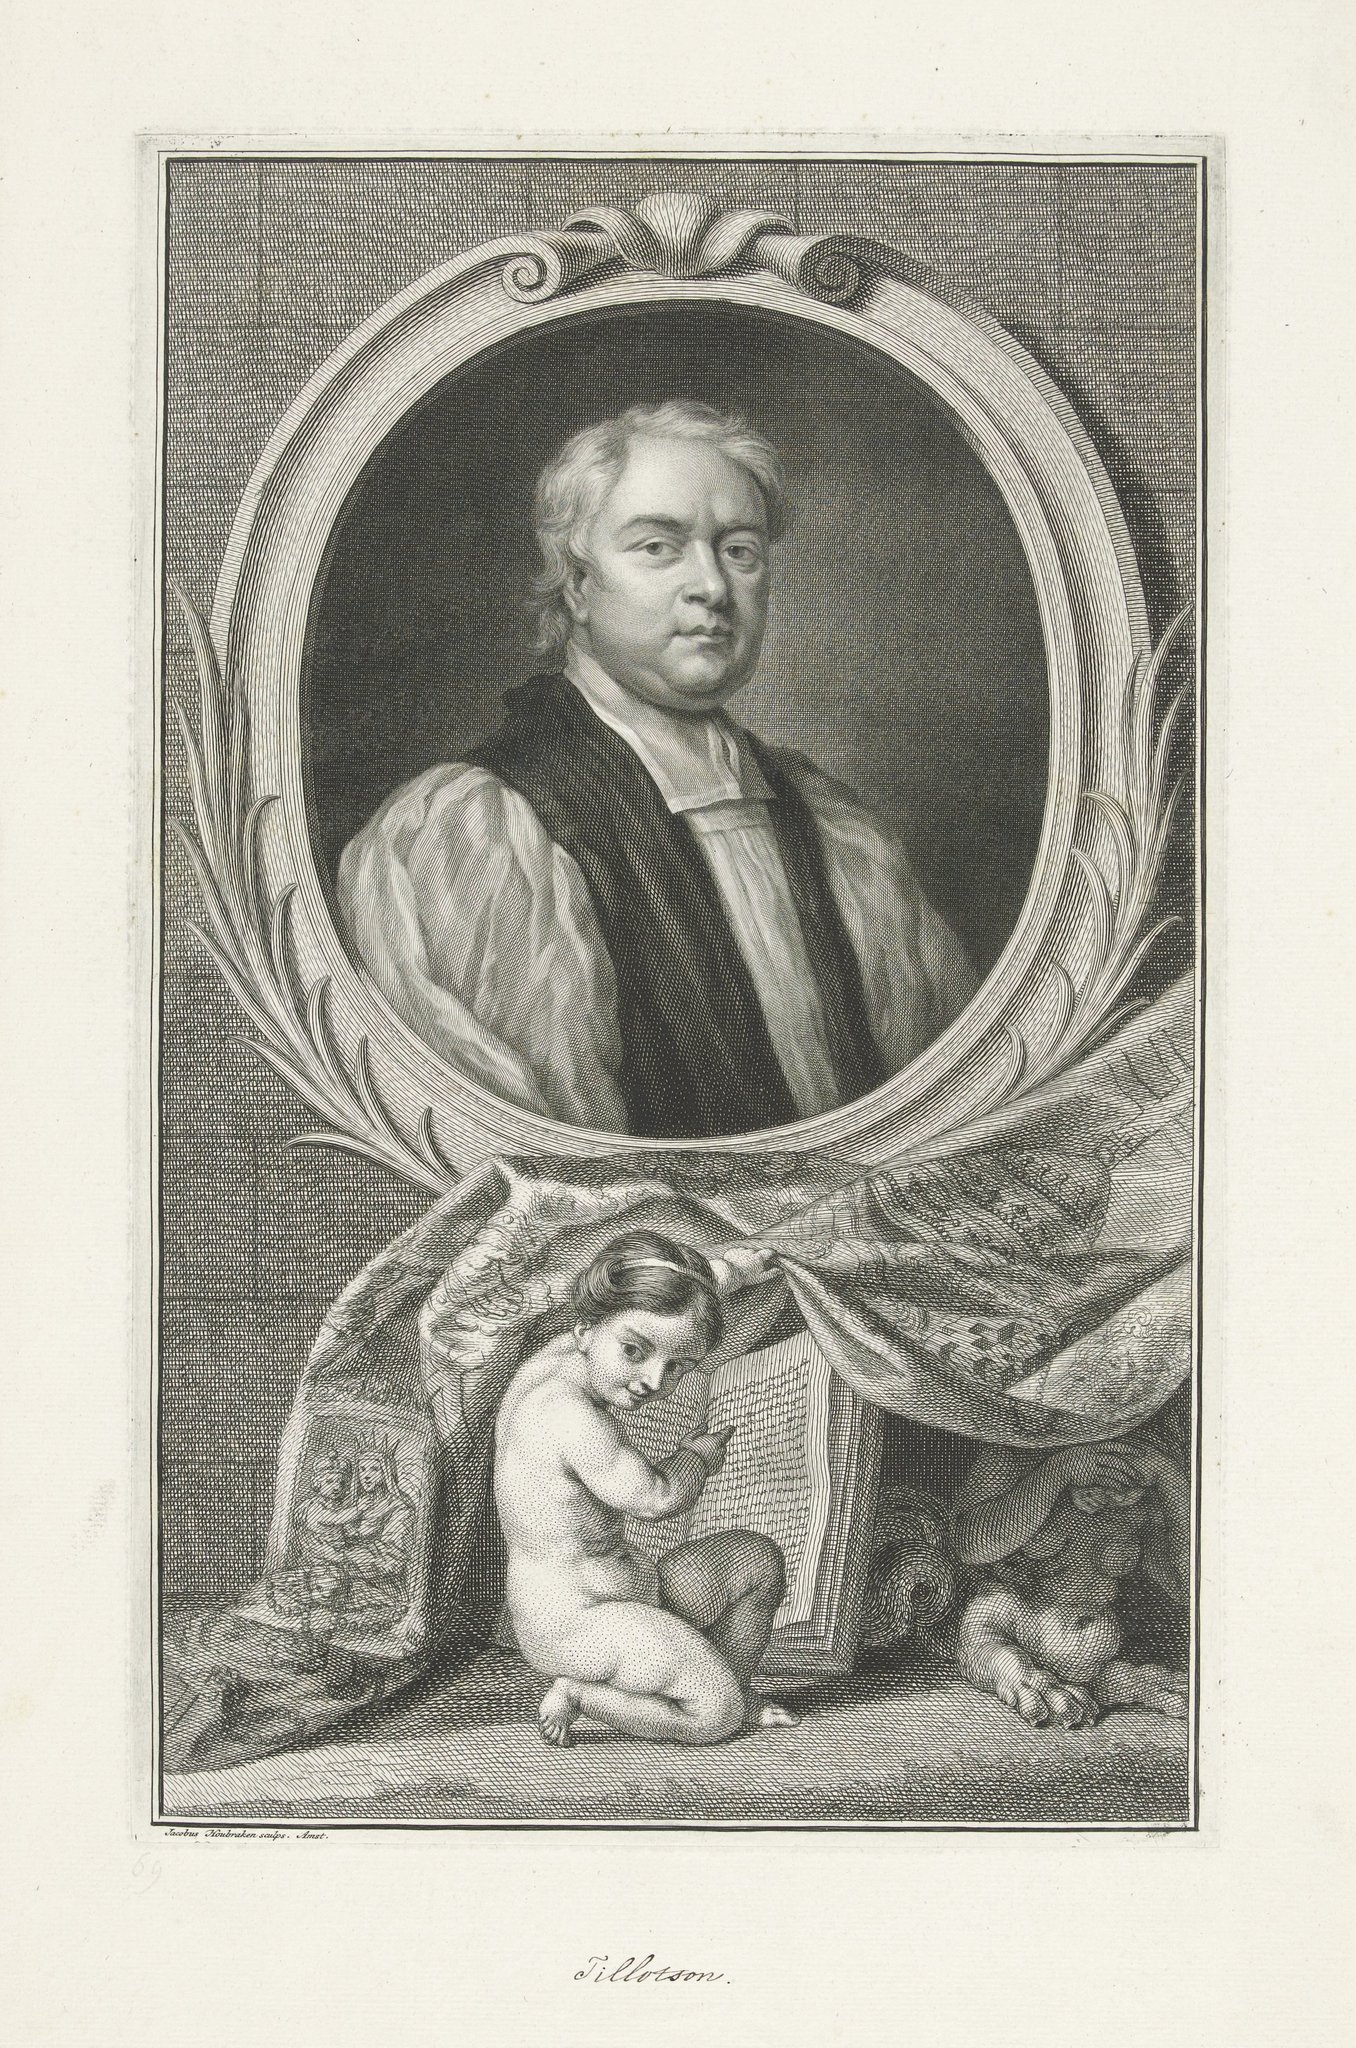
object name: print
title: Portret van John Tillotson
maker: jacob houbraken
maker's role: draughtsman, print maker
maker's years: 1698-1780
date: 1741-1743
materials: paper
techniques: engraving, etching, pen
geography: amsterdam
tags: clergyman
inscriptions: collector's mark: Lugt 240, name: ‘Tillotson’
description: Prent ook gebruikt in: Thomas Birch. The heads of illustrious persons of Great Britain : engraved by Houbraken, and Vertue, with their lives and characters. London: John en Paul Knapton, 1743-1751.